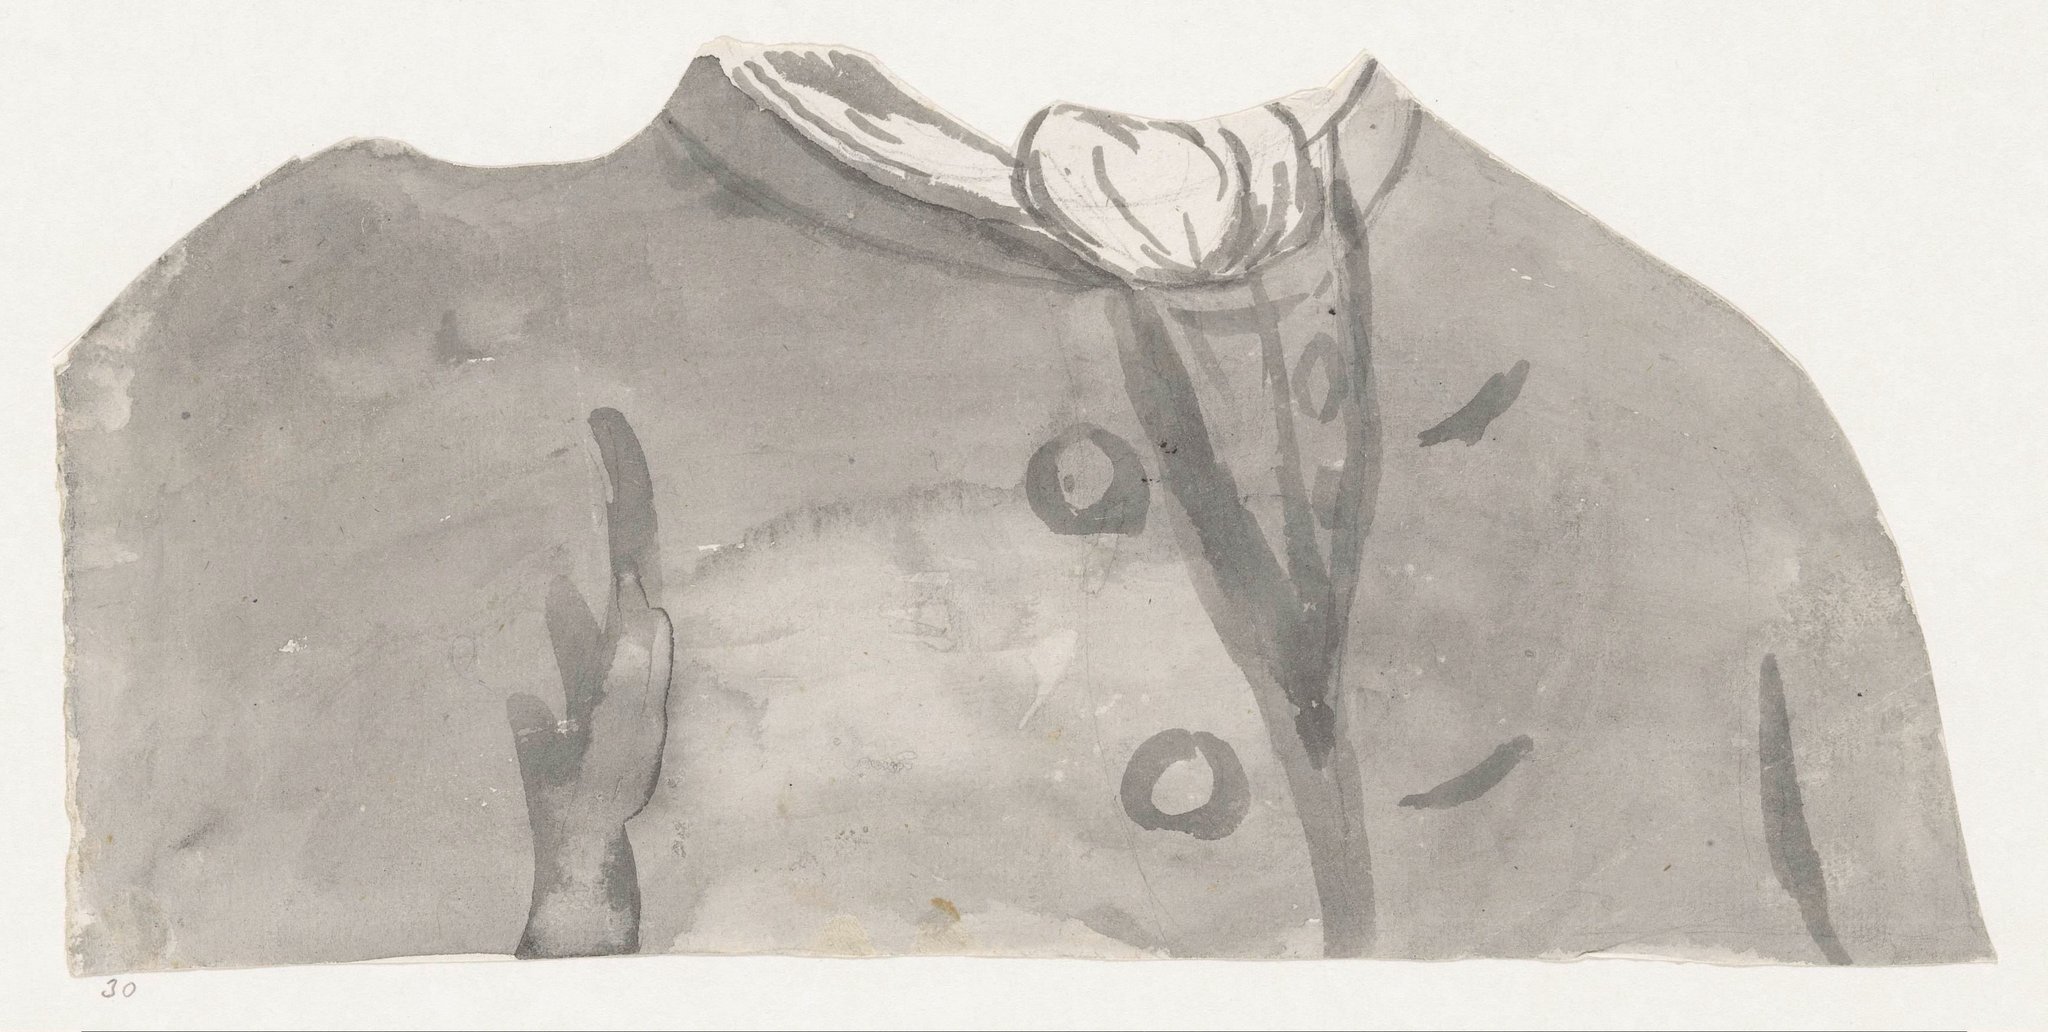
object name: drawing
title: Uitgeknipt deel van een kledingstuk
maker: jan brandes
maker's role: draughtsman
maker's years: 1743-1808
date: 1788-1808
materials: ink, paper, pencil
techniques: brush, snipping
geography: skälsebo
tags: coat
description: Borststuk zonder hoofd, alleen de schouders, kraag en borst van een jas, helemaal vrijgeknipt.